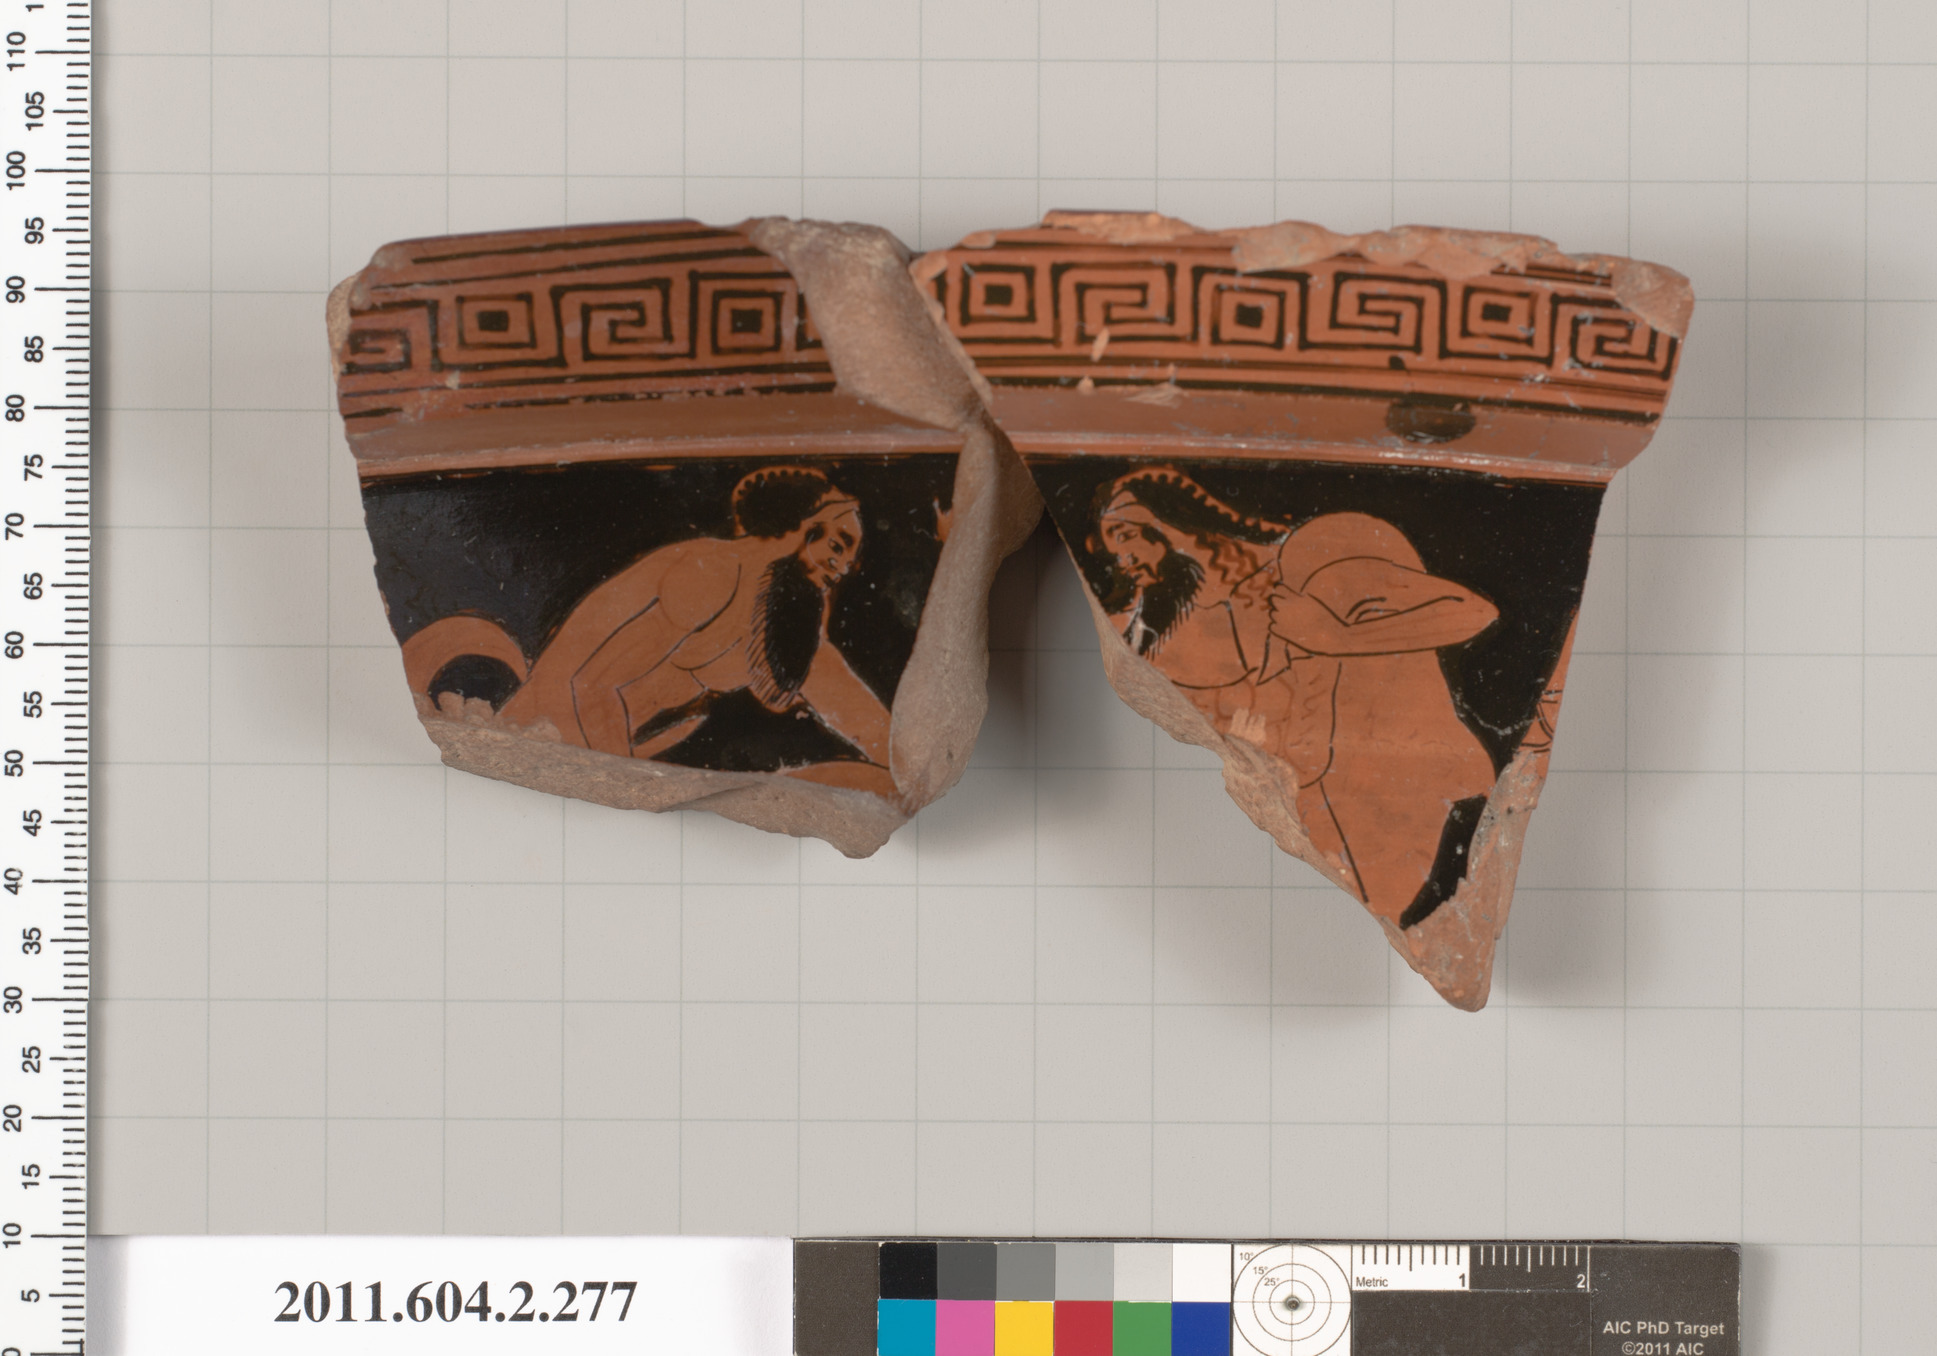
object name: volute krater fragment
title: Terracotta fragment of a volute-krater (bowl for mixing wine and water)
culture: greek, attic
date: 500-475 BCE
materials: terracotta